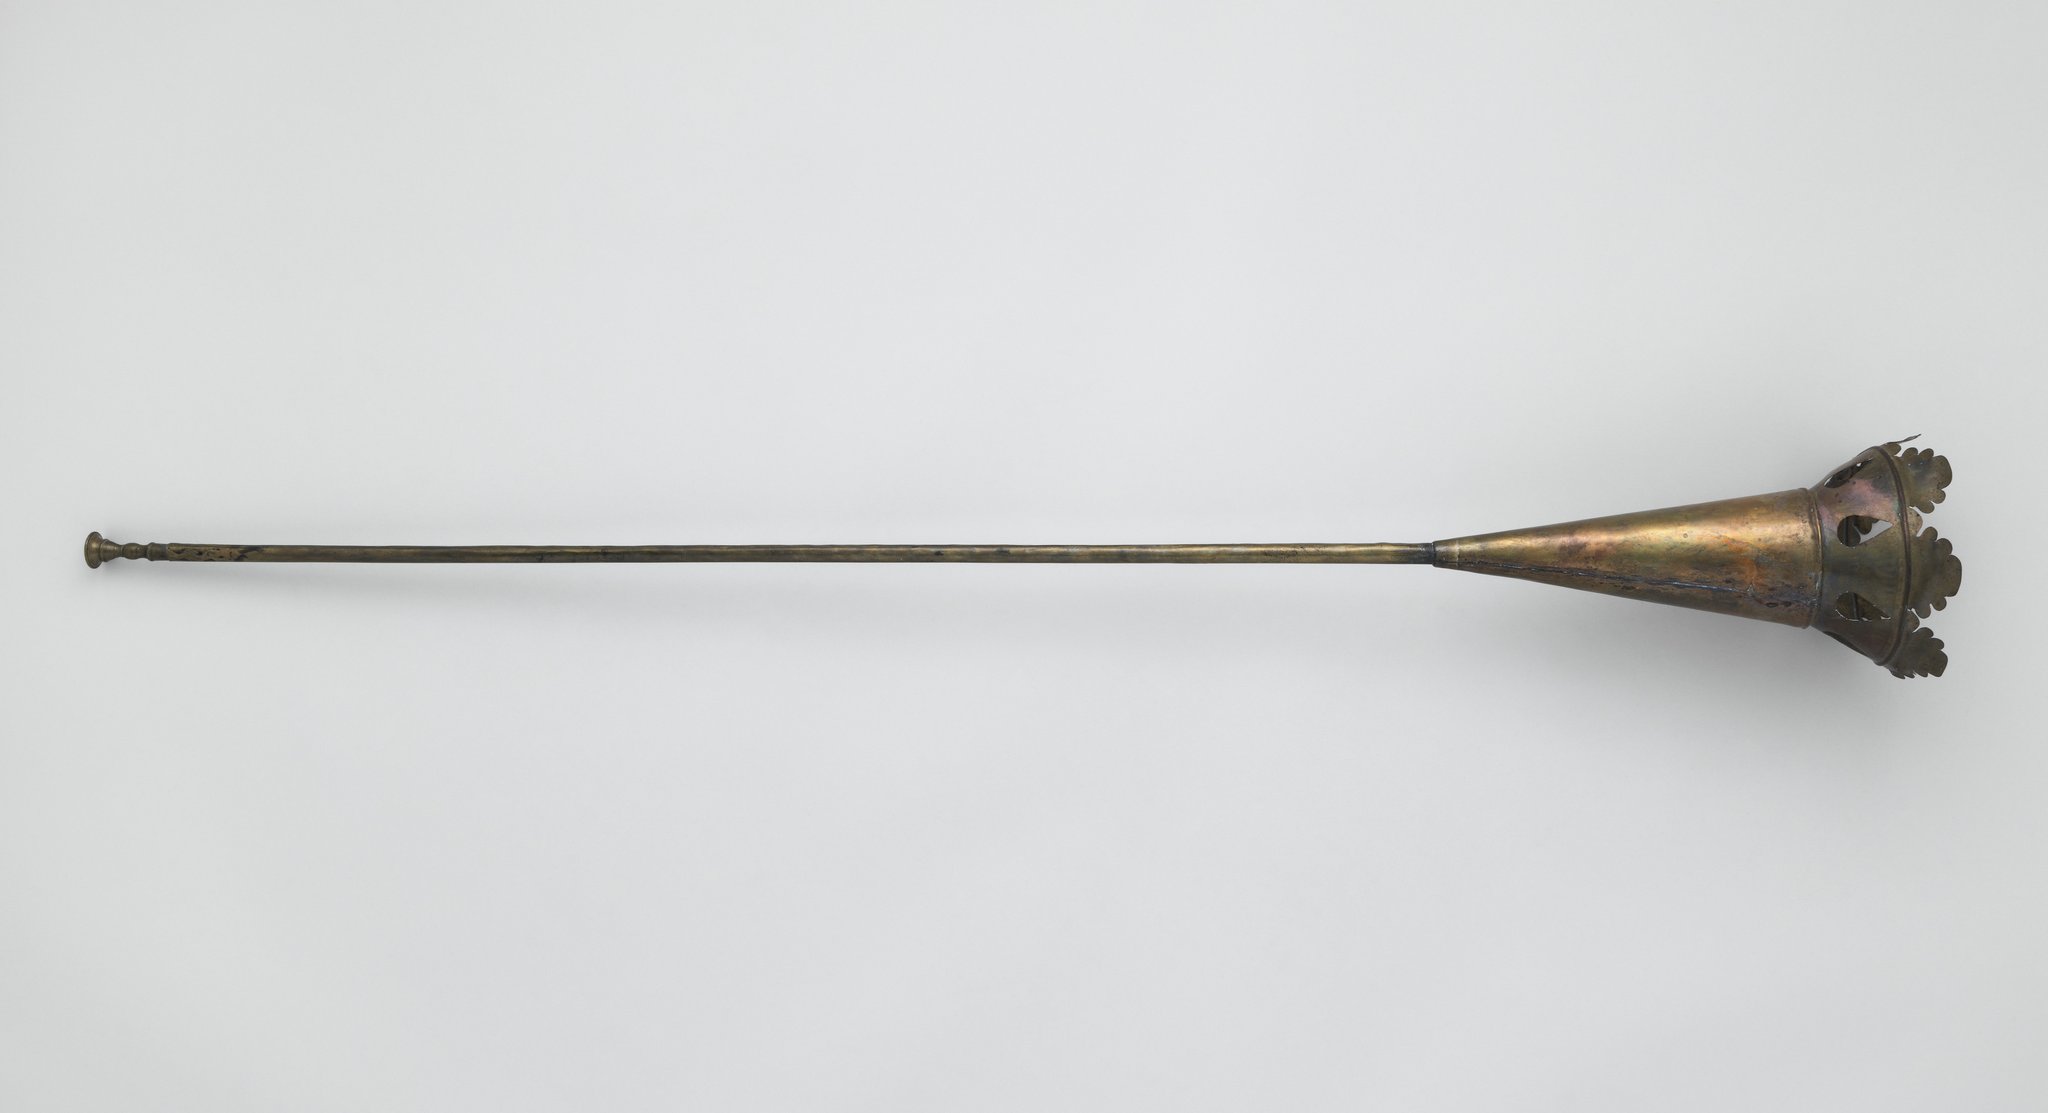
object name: karnā trumpet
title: Karnā (Trumpet)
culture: indian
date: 1867-1900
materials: brass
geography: india